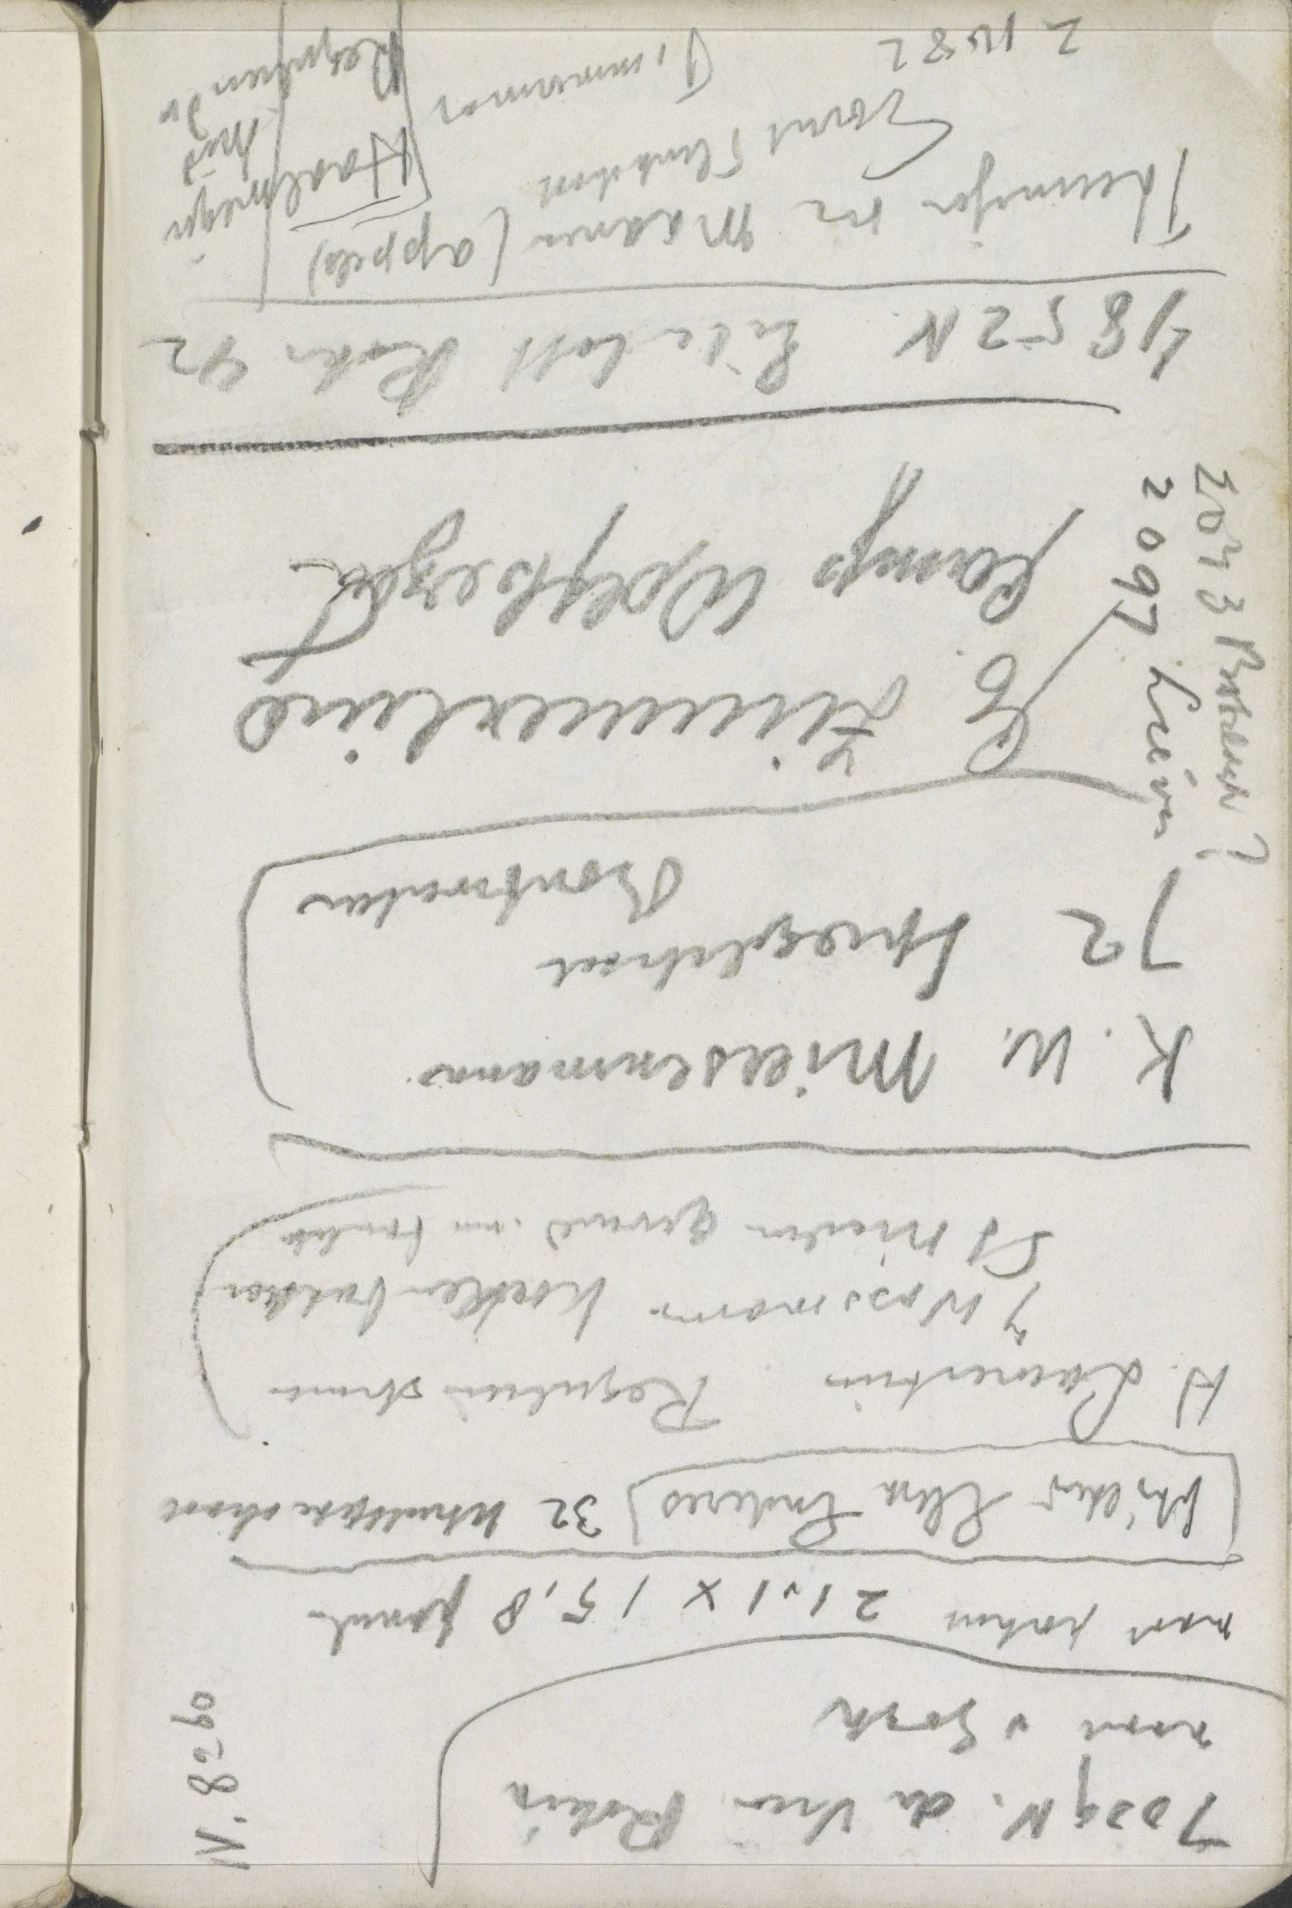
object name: sketchbook leaf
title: Annotaties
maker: george hendrik breitner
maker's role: draughtsman, painter, print maker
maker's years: 1857-1923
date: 1917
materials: paper, pencil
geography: amsterdam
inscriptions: size, annotation: ‘7029N de Vries Rokin/ naar v. Gogh/ [...]/ H. Laurentius Regulierstraat/ b/ Wassmann koekenbakker/ [...]/ K.W. Miersenmann/ 72 Spiegelstraat/ [...]/ Zimmerling/ langs Wolfhezen/ 4852N. Liselott[?] Rokin 42/ [...]’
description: Pagina 90 uit een schetsboek met 44 bladen.